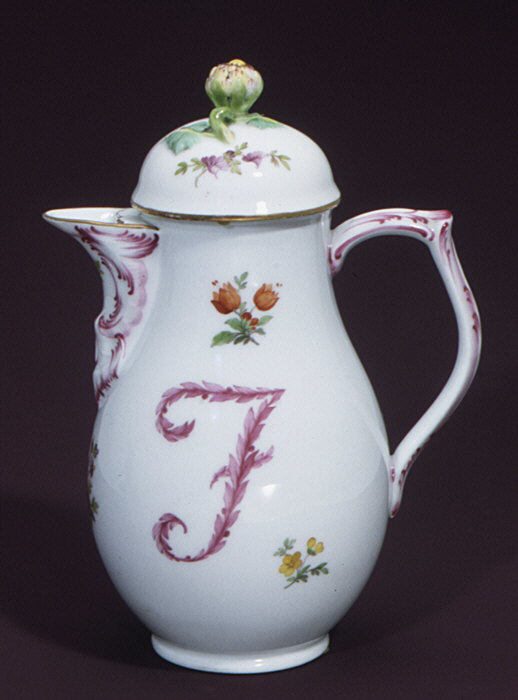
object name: coffeepot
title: Coffeepot (part of a set)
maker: royal porcelain manufactory, berlin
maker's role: manufactory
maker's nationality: german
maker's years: 1763-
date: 1765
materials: hard paste porcelain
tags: flowers,insignia